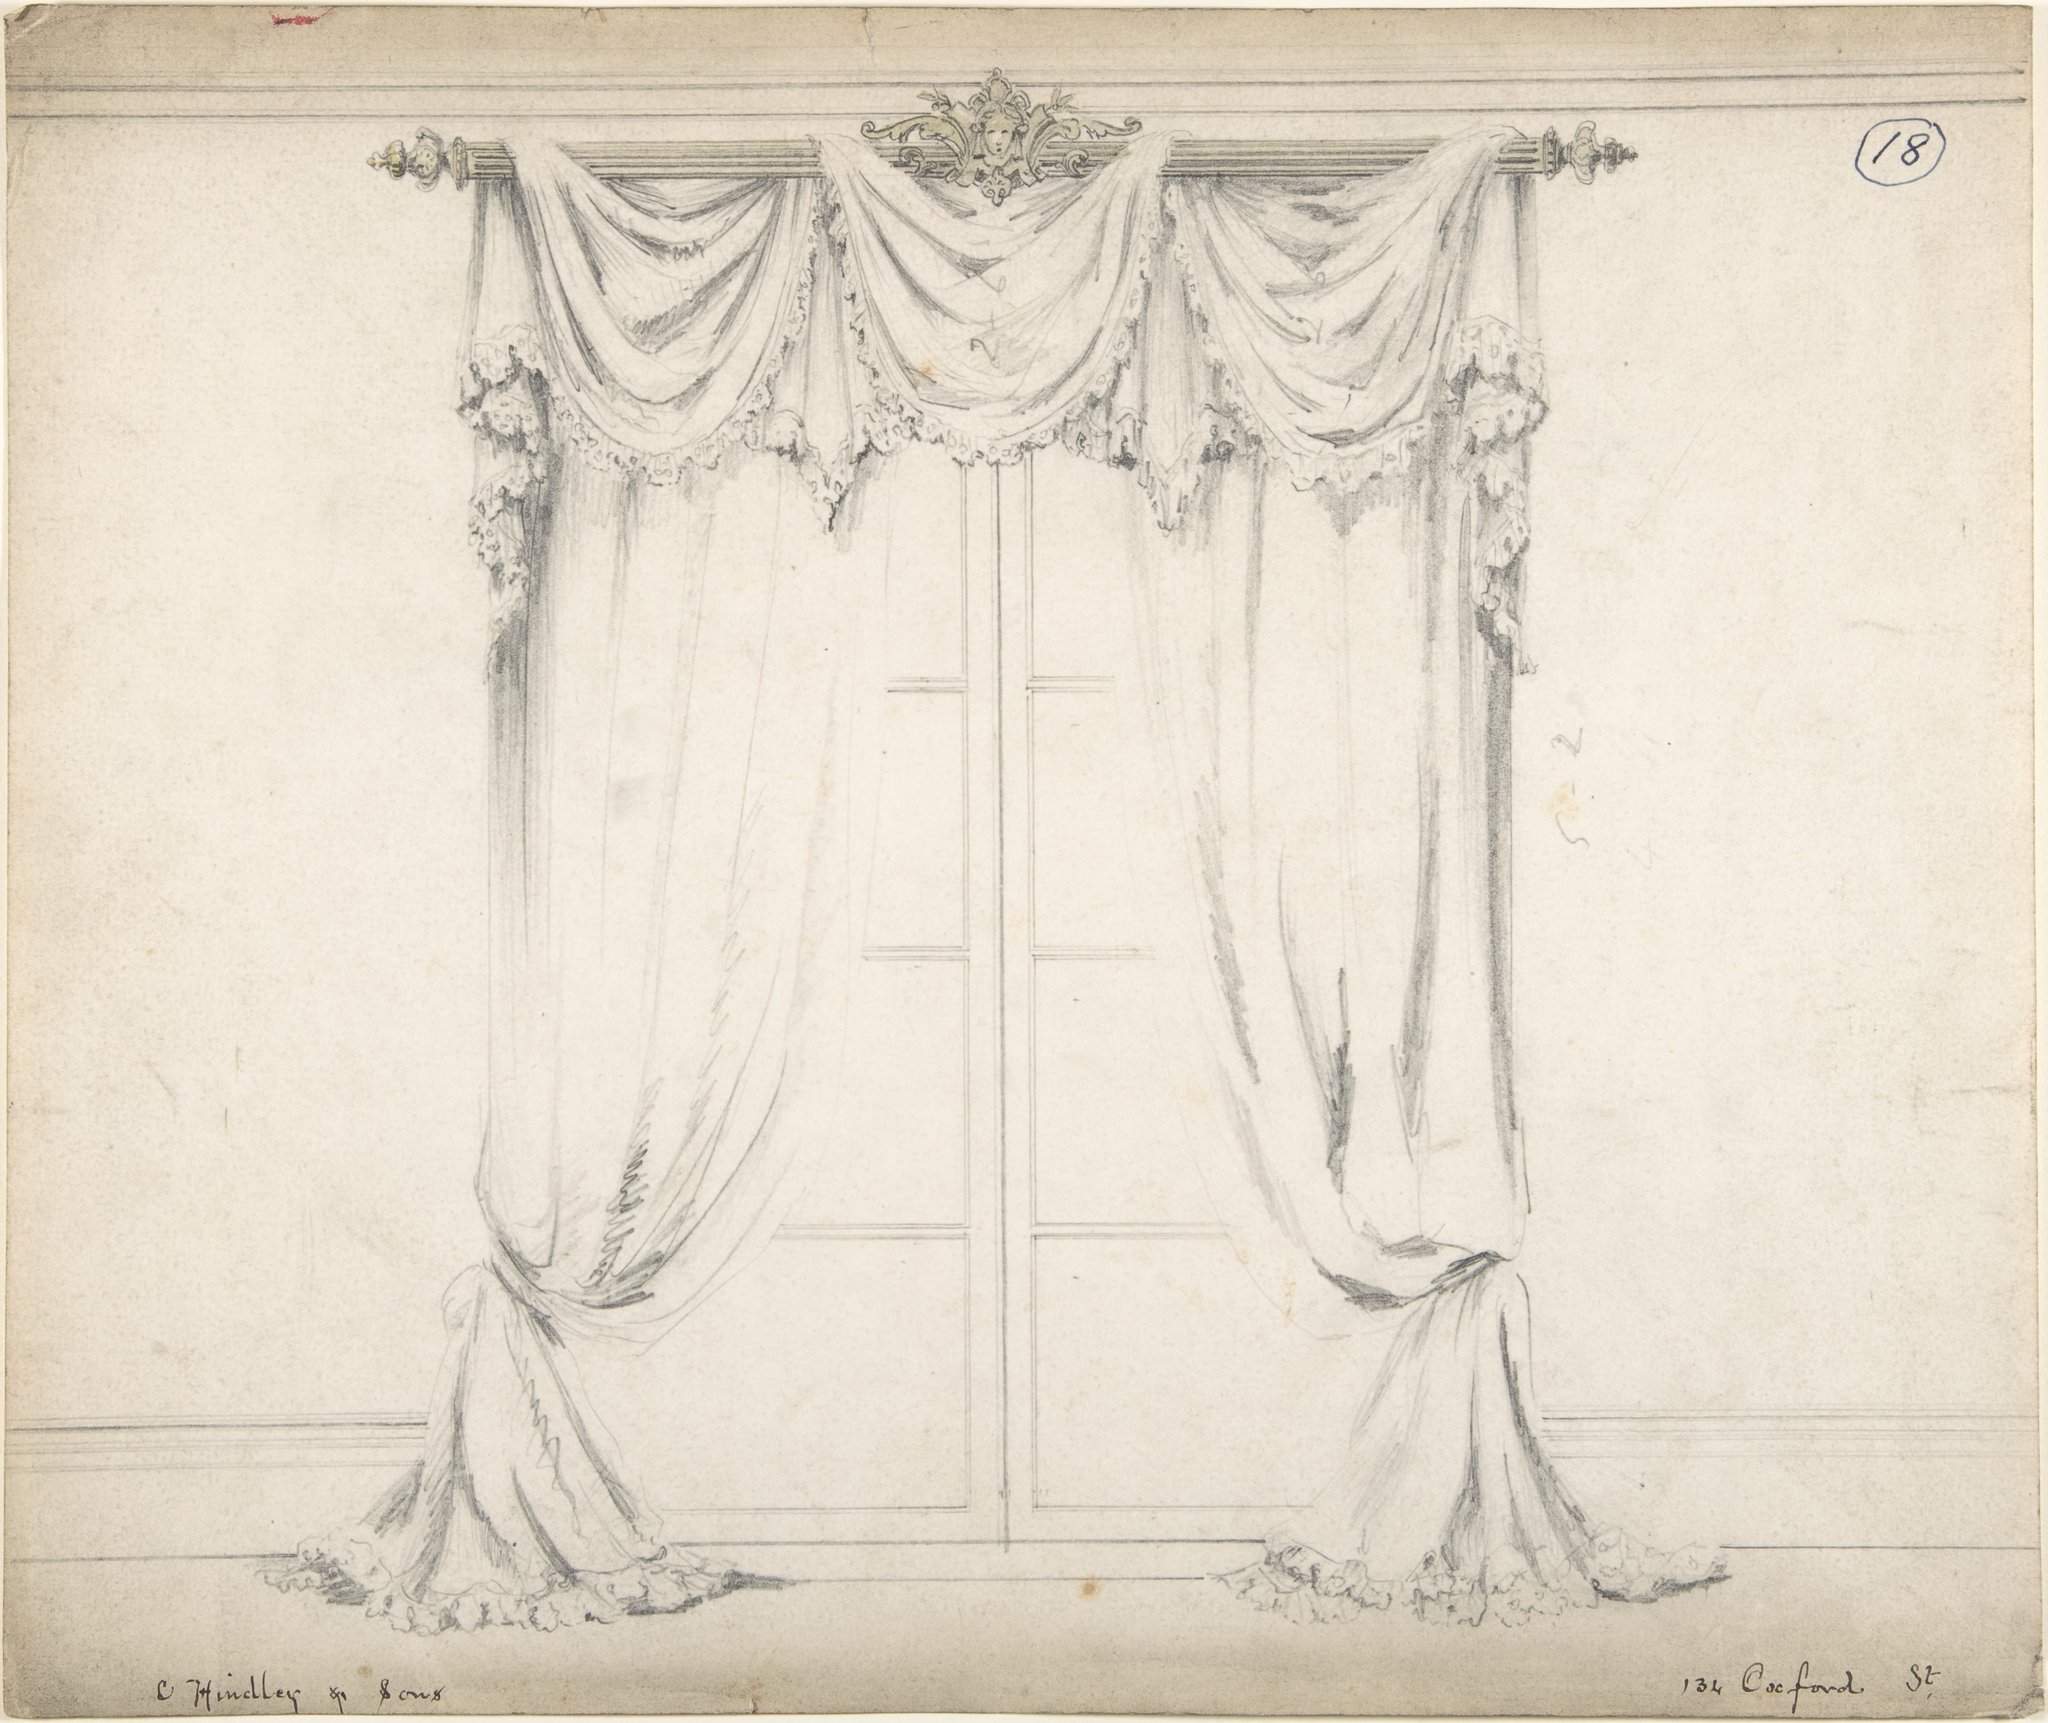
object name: drawing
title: Design for Curtains and Rod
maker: charles hindley and sons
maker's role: artist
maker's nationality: british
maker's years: 1841-1917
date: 1841-1884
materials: graphite, ink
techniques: brush, wash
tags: curtains